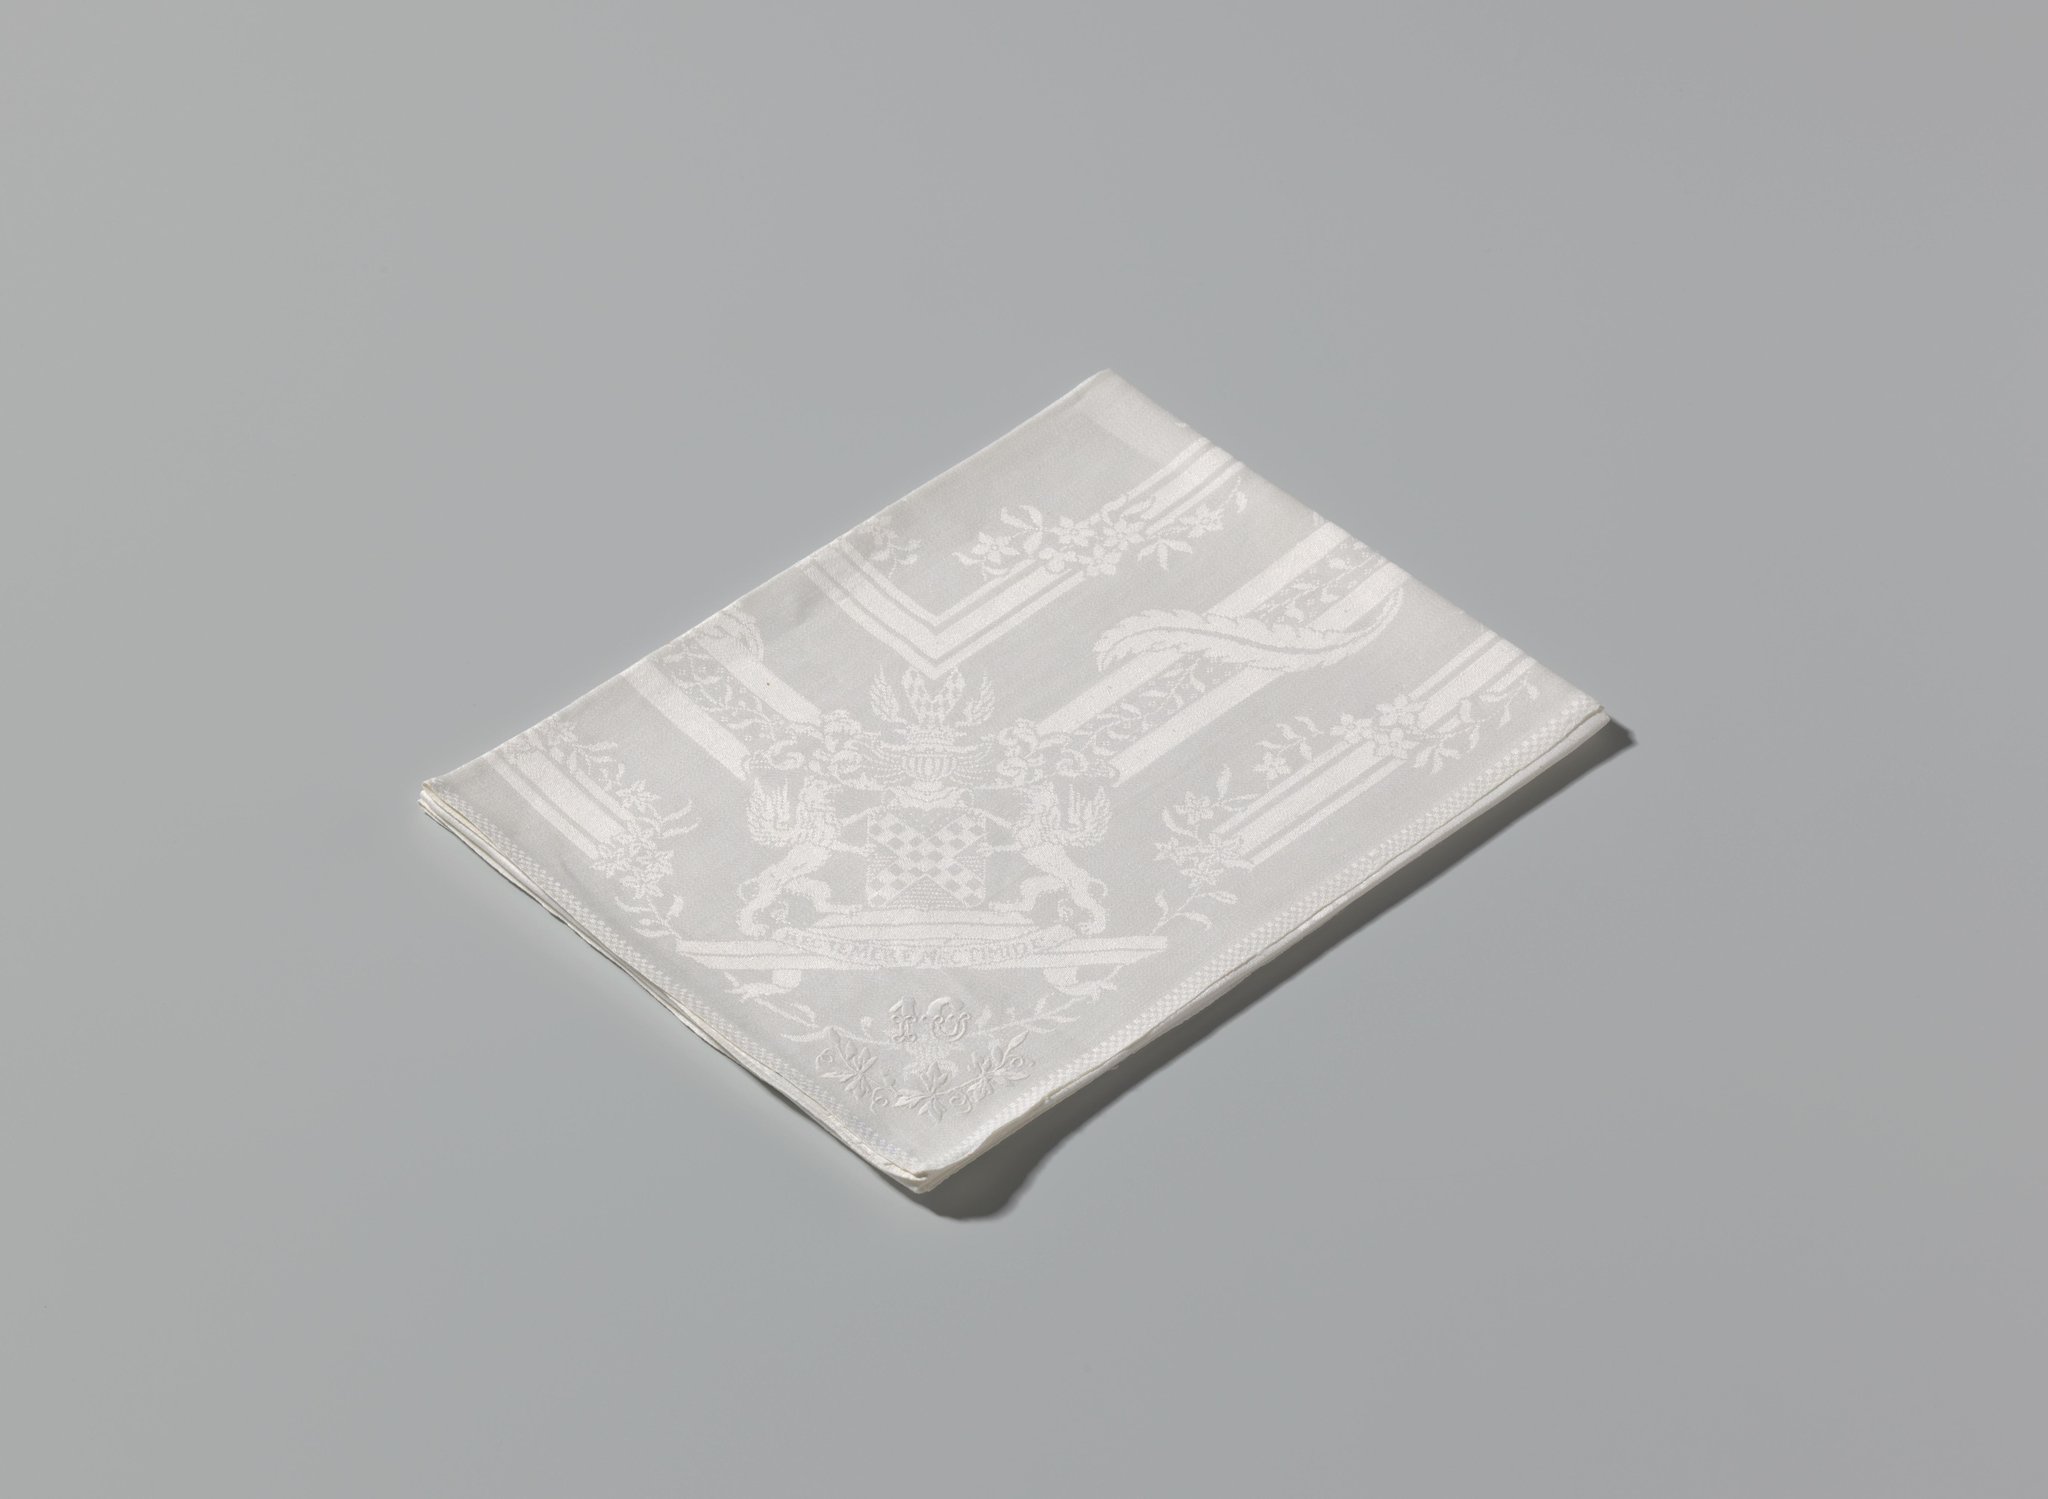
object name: napkin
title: Servet met het familiewapen Van der Dussen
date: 1870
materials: linen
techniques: damask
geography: boxtel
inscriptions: mark: ‘10’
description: Servet van linnendamast met het familiewapen Van der Dussen. Middenveld: wapenschild temidden van gestrooide bloemknoppen. Randen: drie drievoudige banden, de middelste met een bladrank, de andere glad en omslingerd met een spiraaltak.